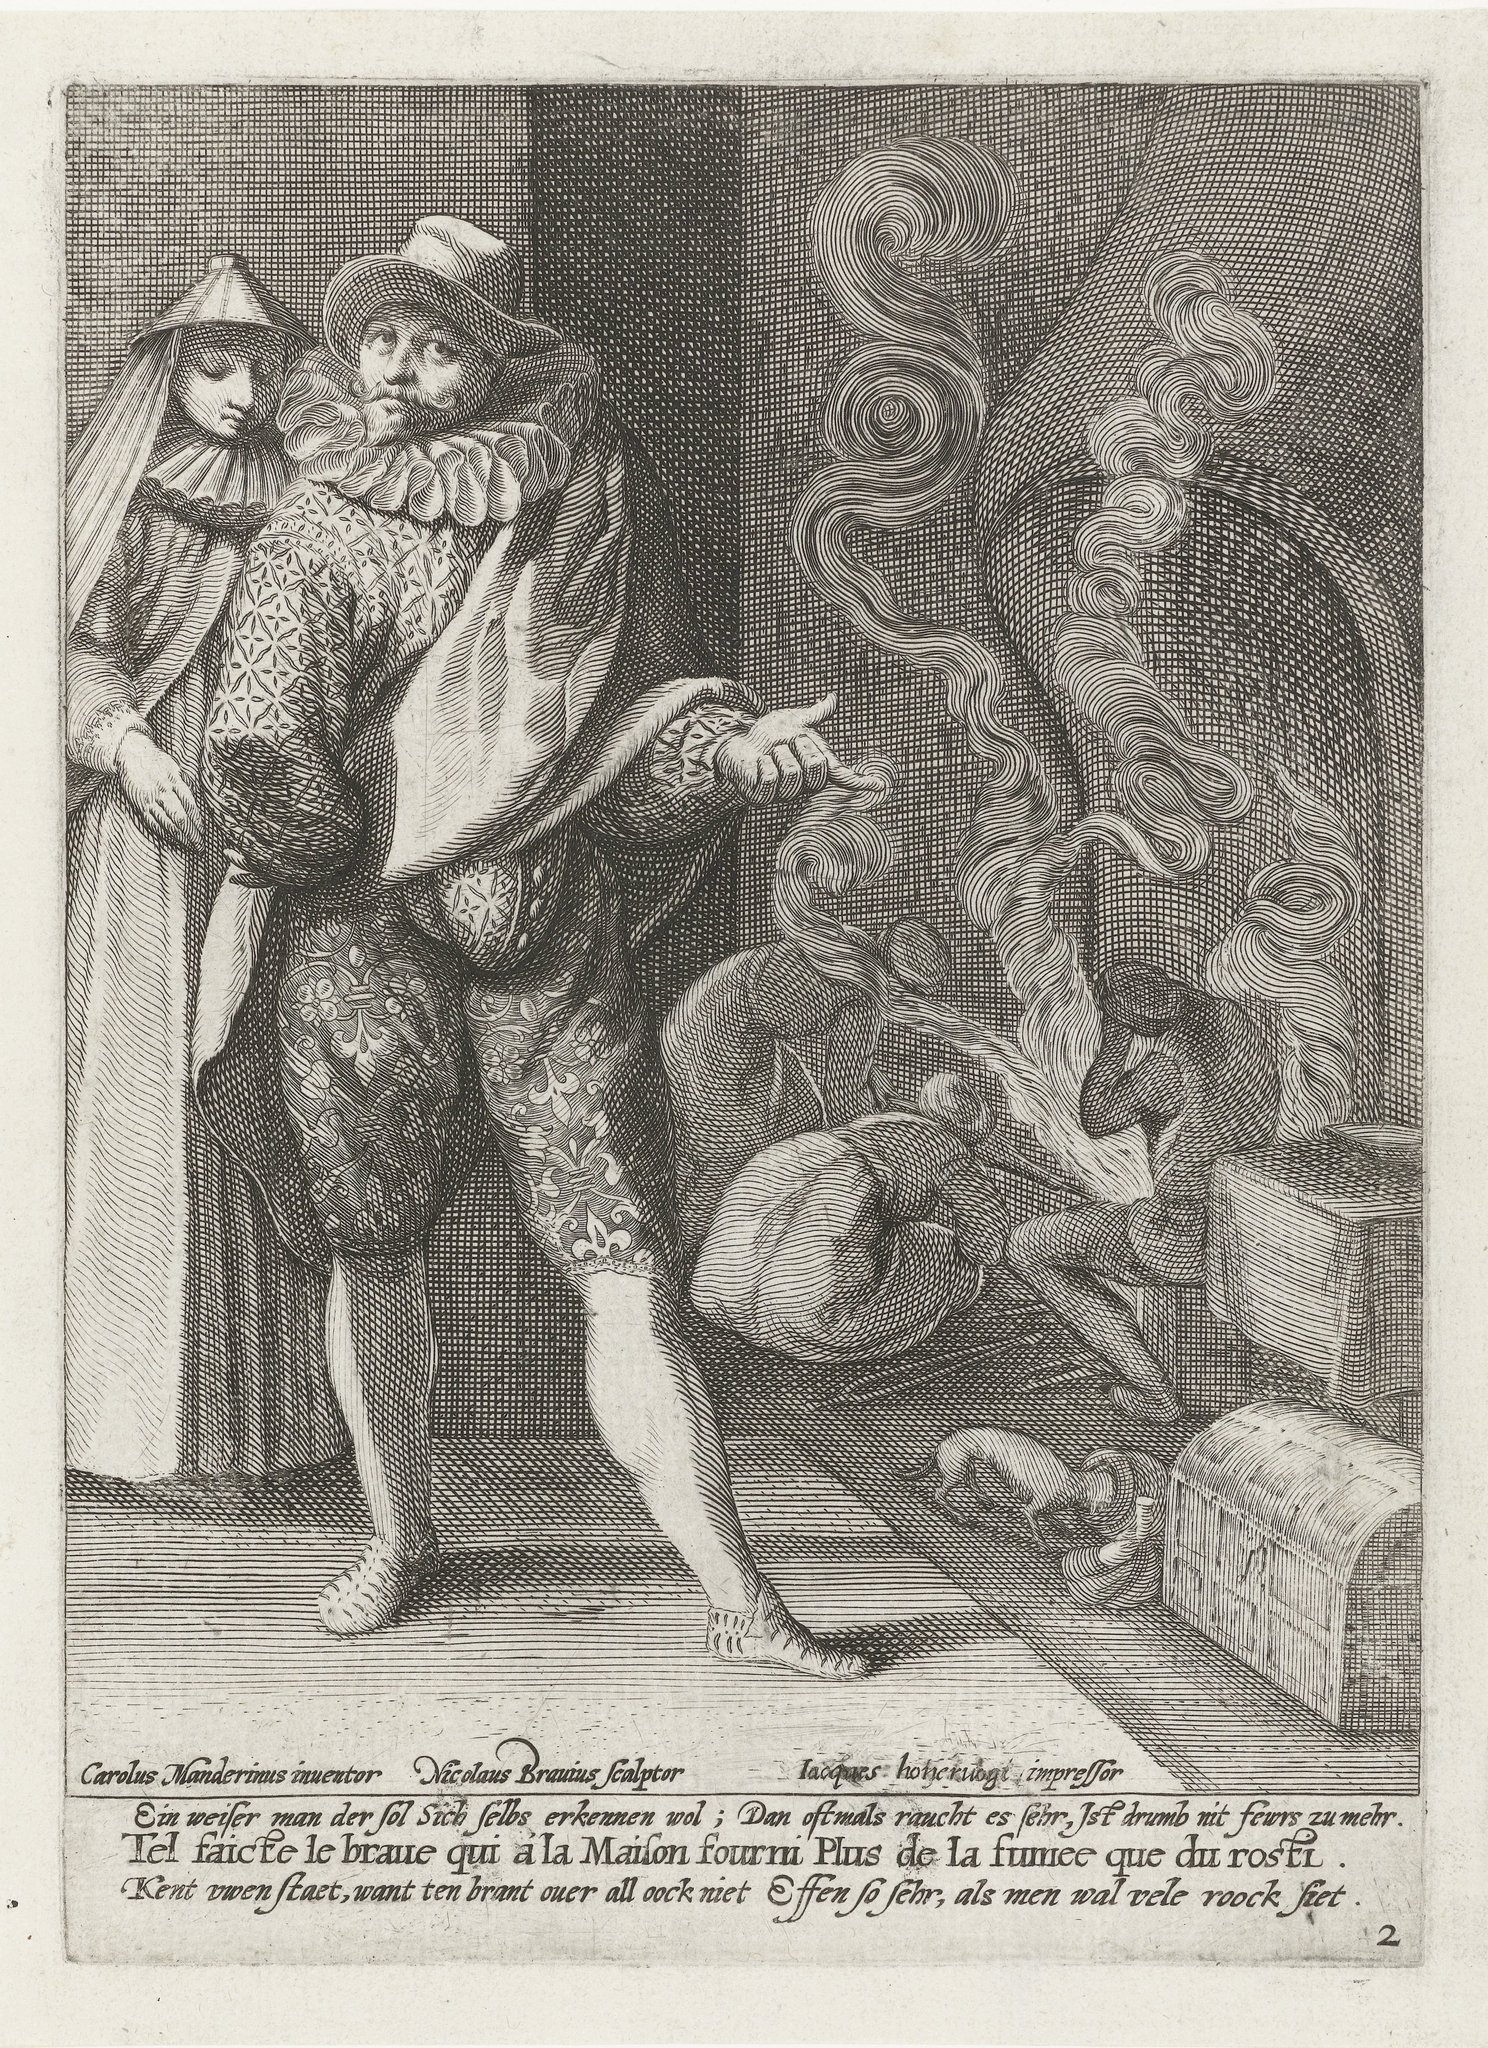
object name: print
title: Vier spreekwoorden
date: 1608-1666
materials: paper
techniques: engraving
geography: haarlem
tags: neck-gear ~ clothing (with name) (+ men's clothes), clothing for the upper part of the body (with name) (+ men's clothes), shoulder-belt, bandoleer (+ men's clothes), cape (huik) (+ women's clothes), head-gear: hat (+ men's clothes), clothes, costume (+ women's clothes), neck-gear ~ clothing (with name) (+ women's clothes), shoes, sandals (+ men's clothes), proverbs, sayings, etc., clothes, costume (+ men's clothes), temperance, moderation; 'misura' (ripa), clothing for the upper part of the body (doublet) (+ men's clothes), sleeves (+ men's clothes), kindling a fire, netherlands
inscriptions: signature: ‘Nicolaus Brauius sculptor’, collector's mark: Lugt 2228, caption: ‘Kent uwen staet, want ten brant over all oock niet Effen so sehr, als men wal vele roock siet.’, signature: ‘Carolus Manderinus inventor’, address: ‘Iacques Honervoigt impressor’, caption: ‘Tel faincte le brave qui a la maison fourni, Plus de la fumee que du rosti’, number: ‘2’, caption: ‘Ein weiser man der sol sich selbs erkennen vol; Dan oftmals raucht es sehr, Ist drumb nit fewr zu mehr’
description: De heer is gekleed in wambuis* met ganzenbuik* en brede gepijpte plooikraag* en kniebroek*. Op zijn hoofd een hoed* met hoge bol slappe rand. Aan de voeten ingesneden instappers. De dame draagt een huik* en een vlieger.